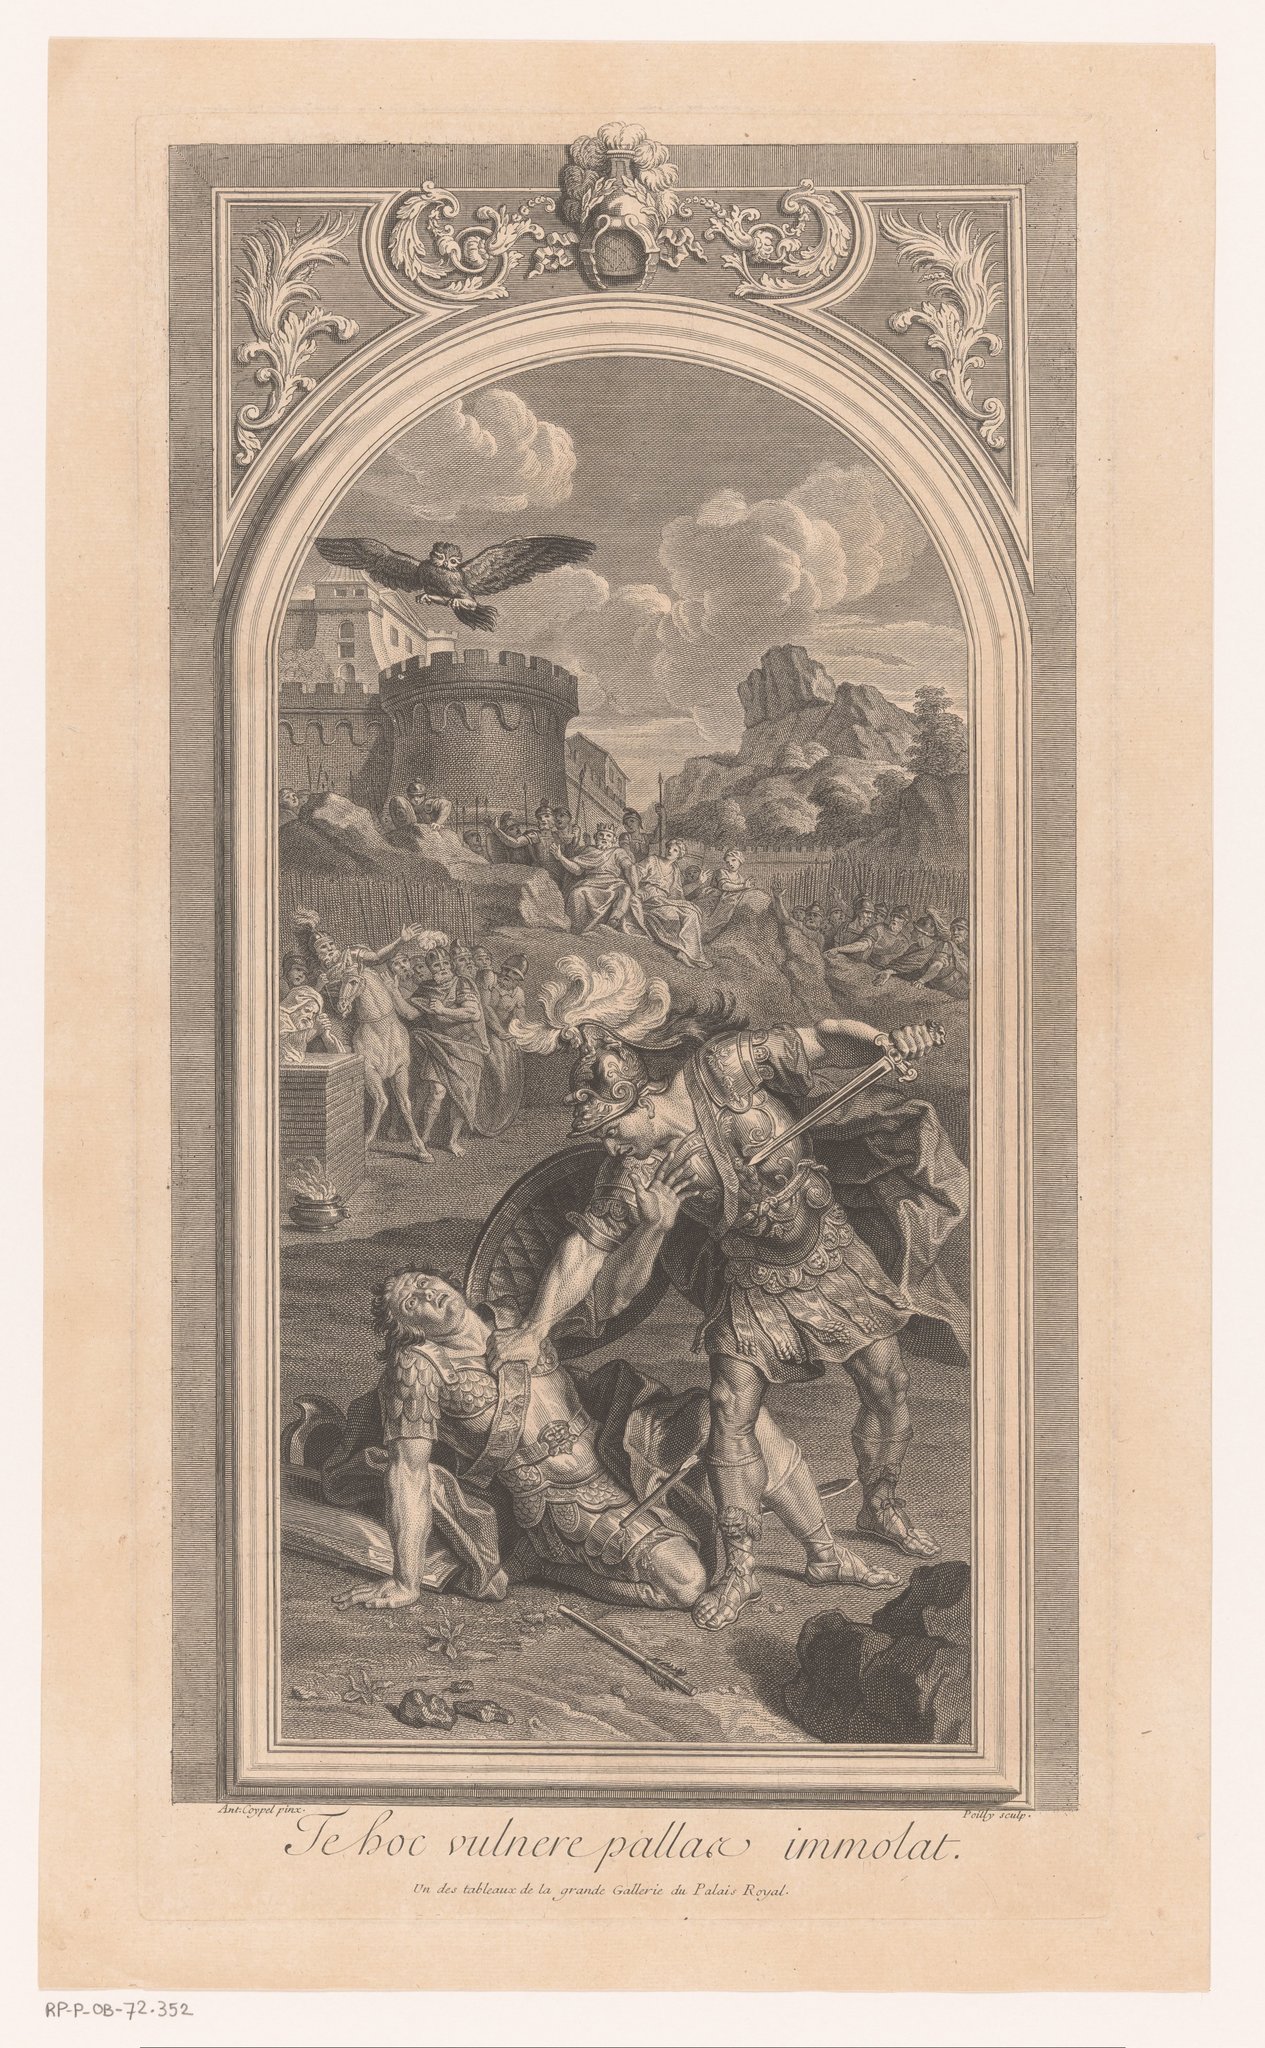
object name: print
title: Te hoc vulnere pallas immolat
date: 1679-1728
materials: paper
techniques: engraving, etching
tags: turnus is killed by aeneas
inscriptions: collector's mark: Lugt 2228